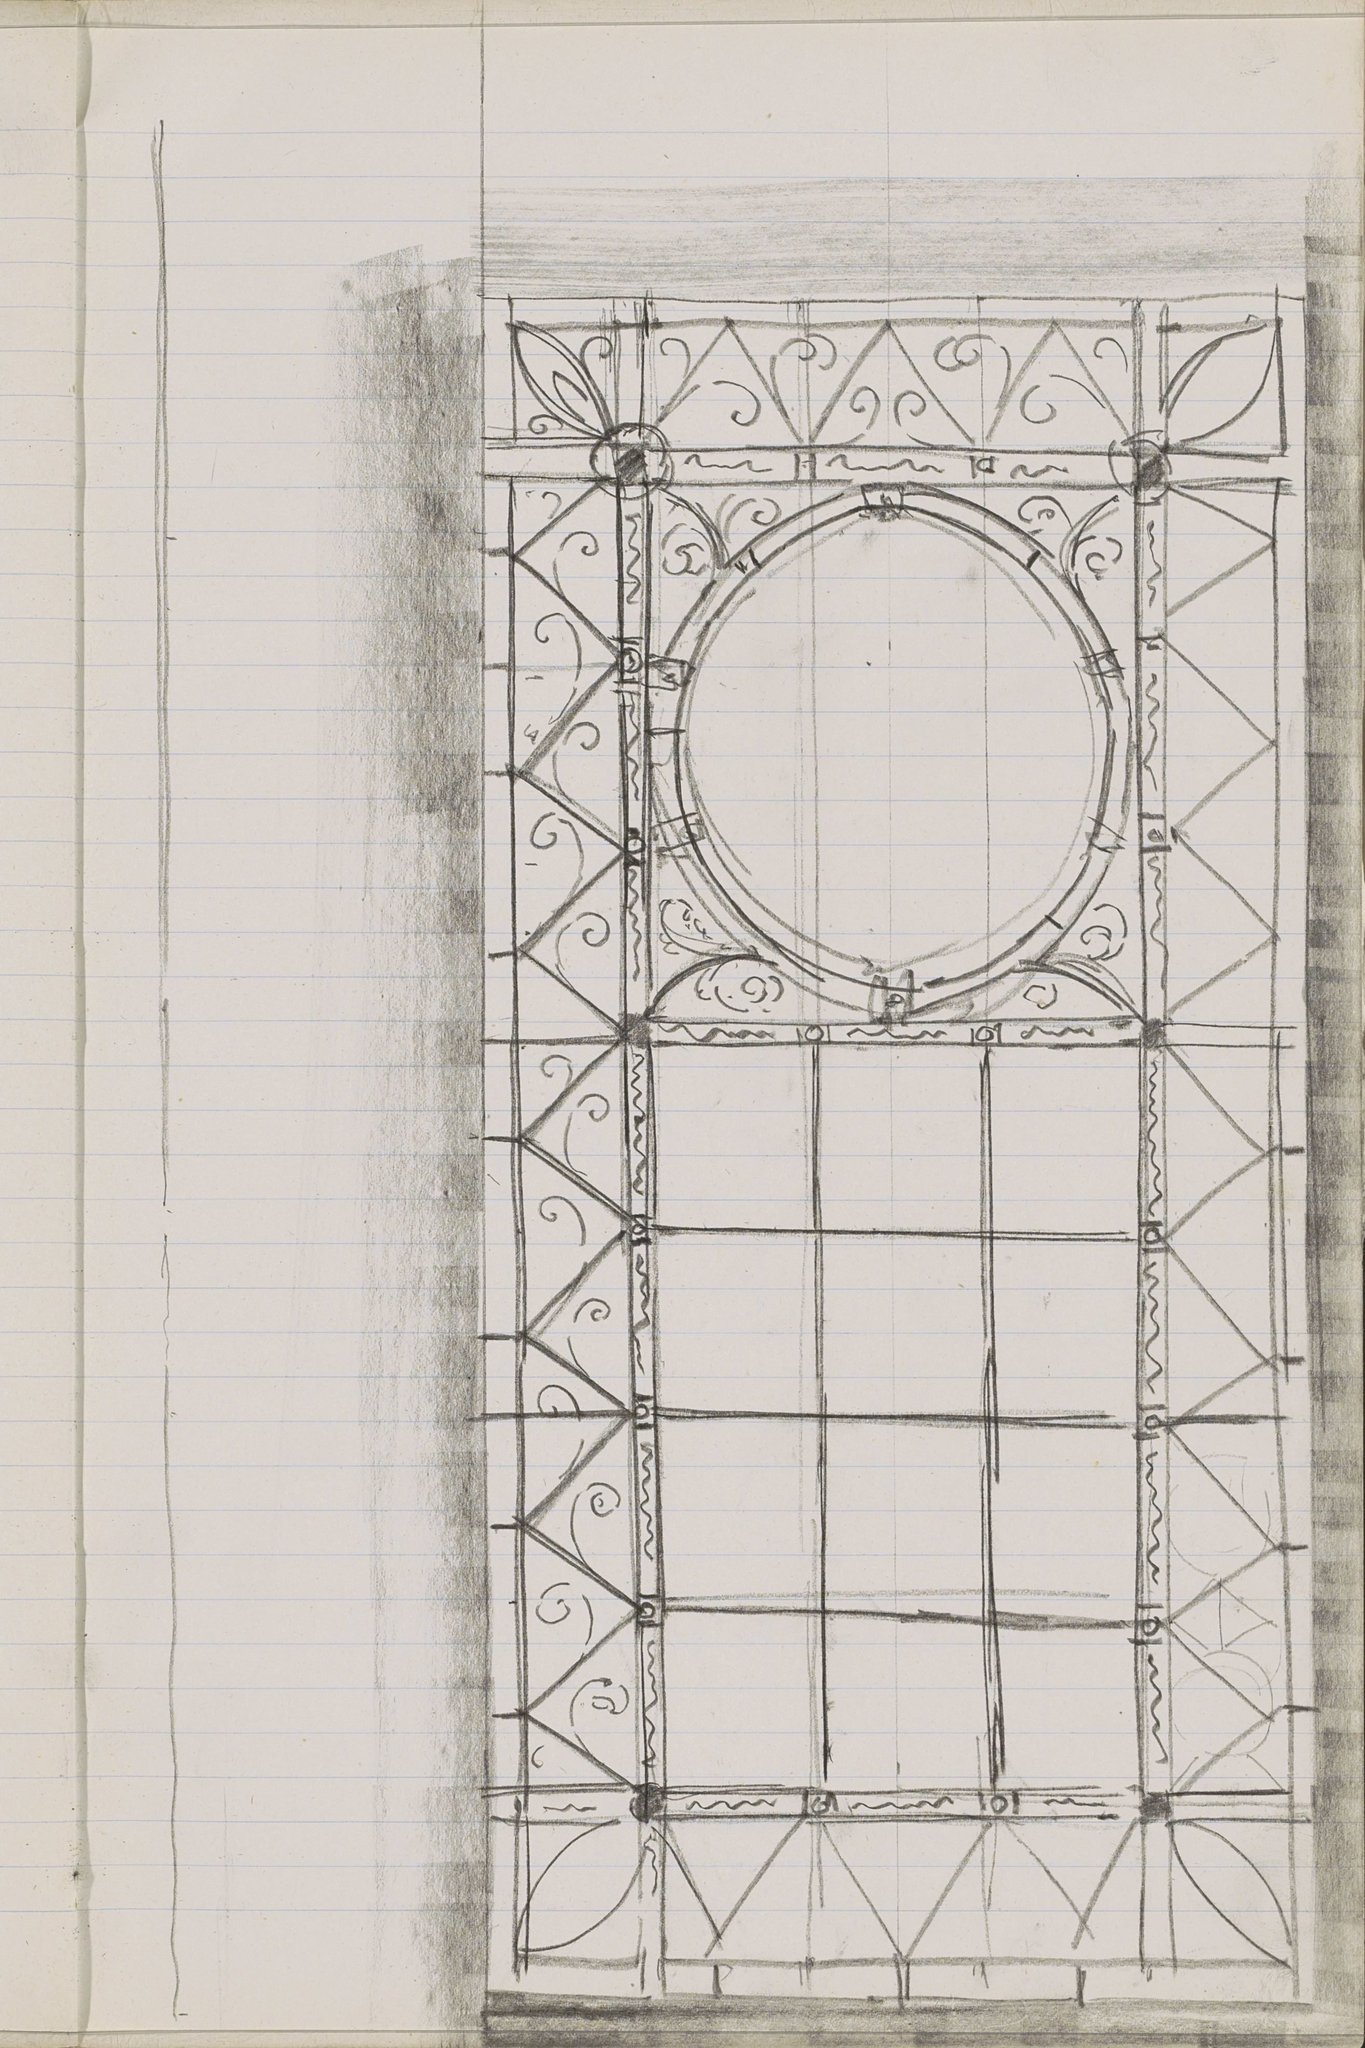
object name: sketchbook leaf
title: Ontwerp voor een glas-in-loodvenster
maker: gerrit willem dijsselhof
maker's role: designer, draughtsman, print maker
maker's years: 1866-1924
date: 1901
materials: chalk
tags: work of applied art (+ types of art)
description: Blad 10 recto uit een schetsboek met 79 bladen.